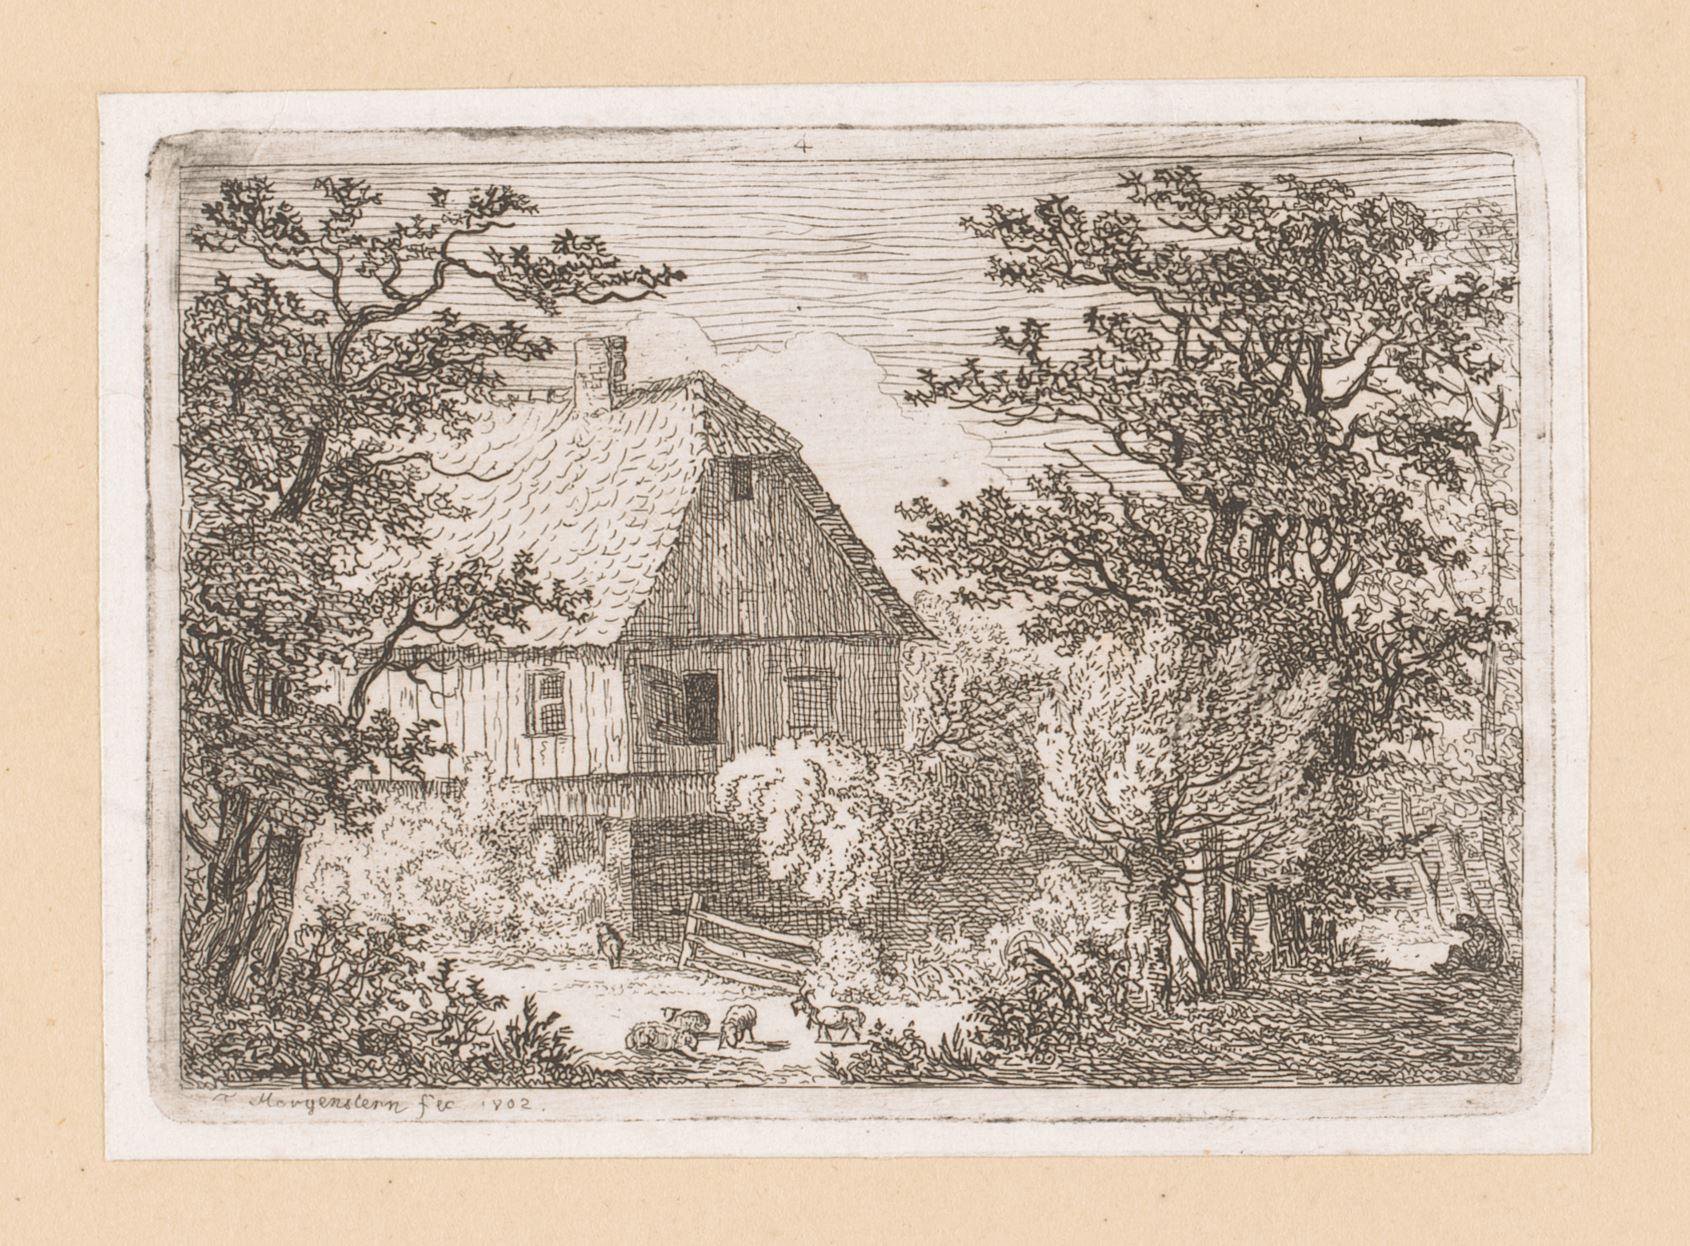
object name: print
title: Gezicht op een landhuis met schapen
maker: johann friedrich morgenstern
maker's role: print maker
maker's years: 1777-1844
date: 1802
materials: paper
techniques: etching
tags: city-view, and landscape with man-made constructions, sheep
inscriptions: collector's mark: Lugt 2228